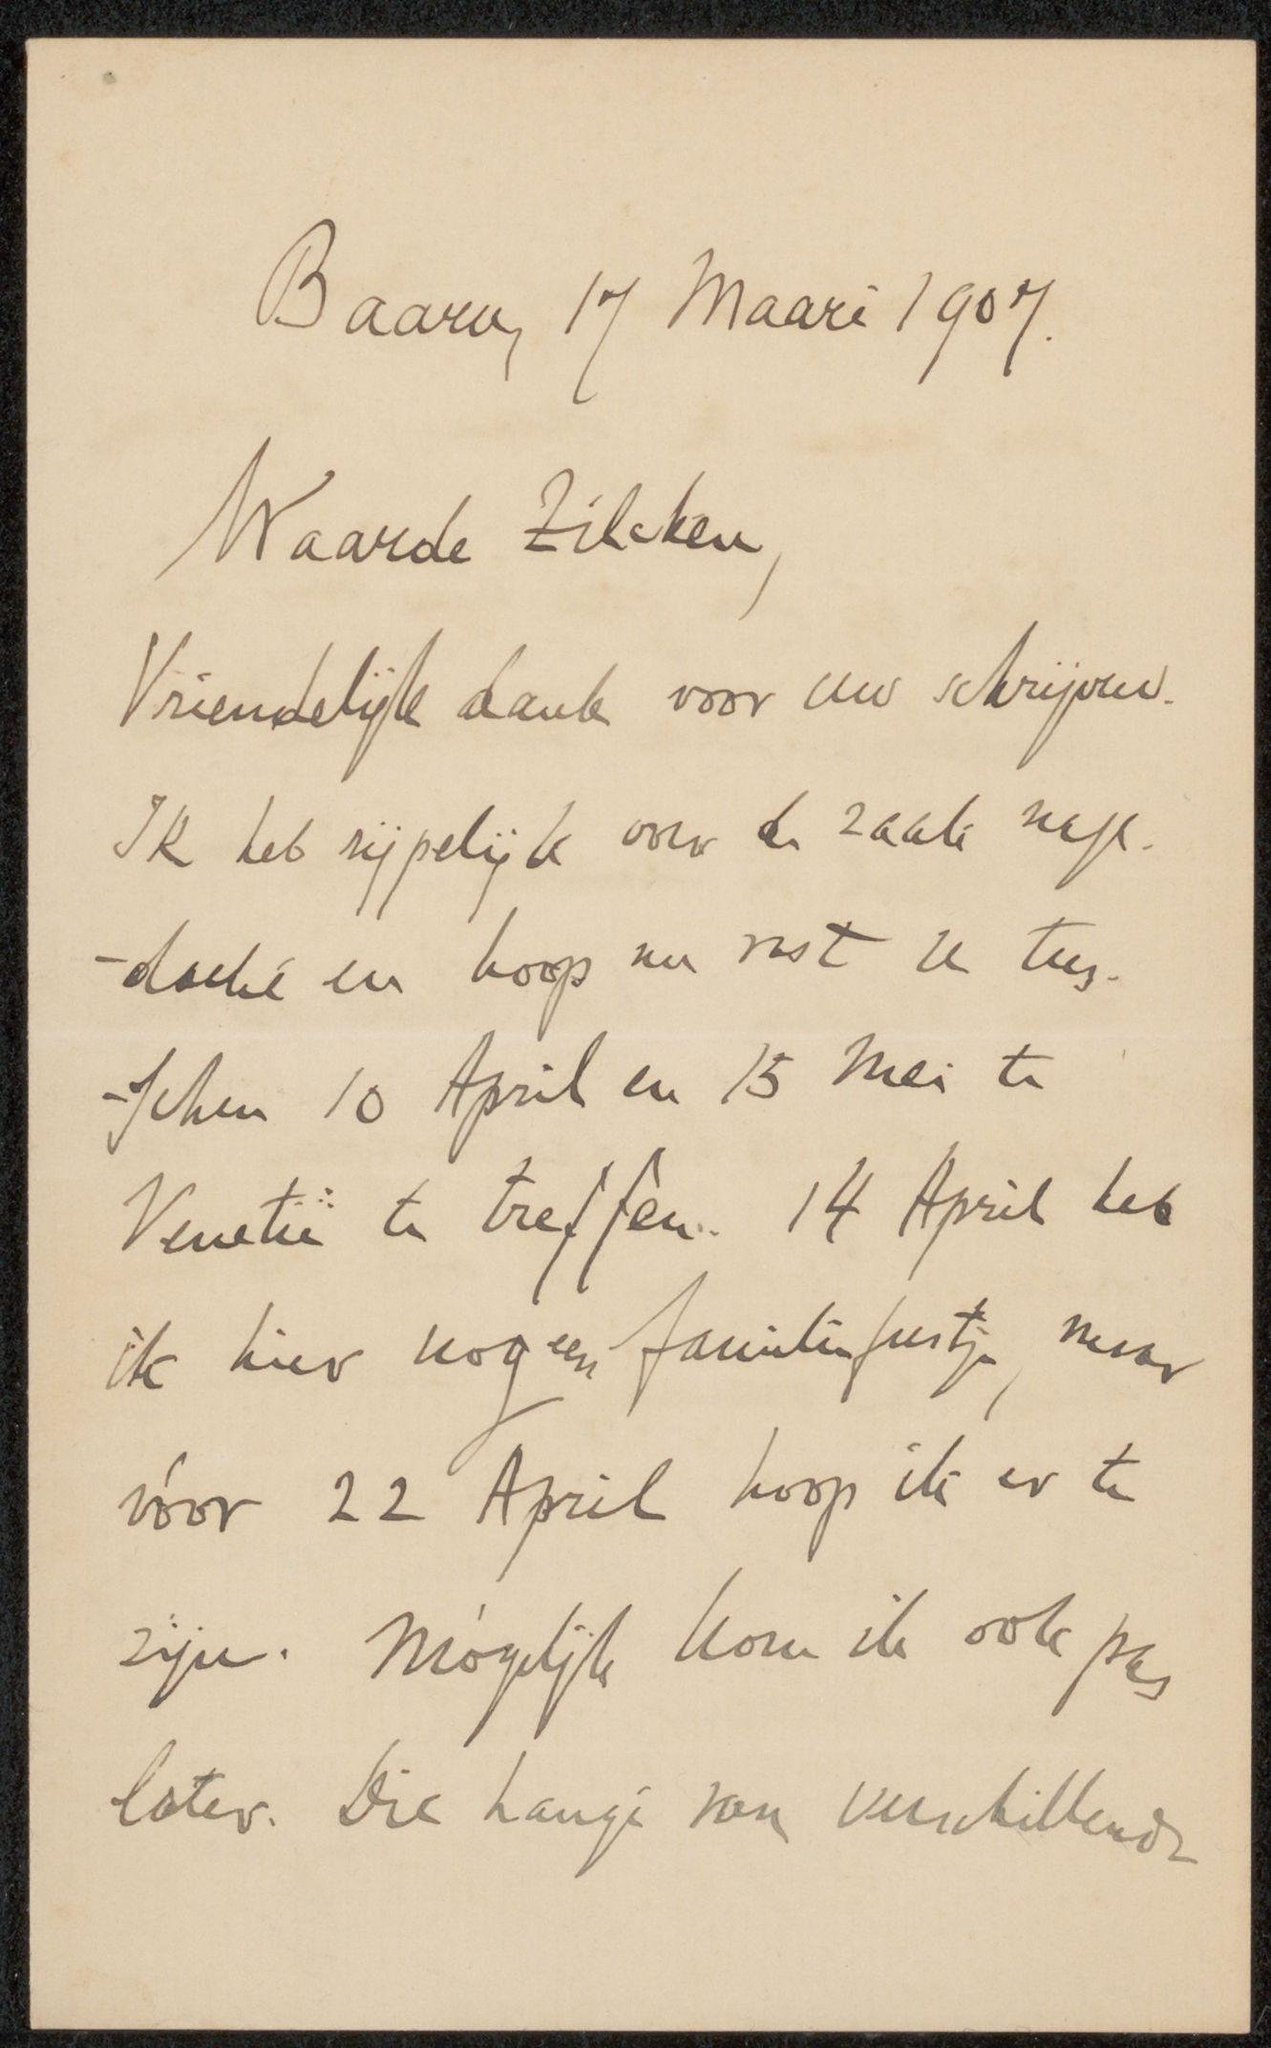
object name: letter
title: Brief aan Philip Zilcken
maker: karel johan lodewijk alberdingk thijm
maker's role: criticus, prozaschrijver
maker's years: 1864-1952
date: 1907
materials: ink, paper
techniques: pen, writing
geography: baarn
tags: the hague, draughtsman, philip zilcken, temporary exhibition, 'salon', venice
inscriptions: collector's mark: ‘RPK’